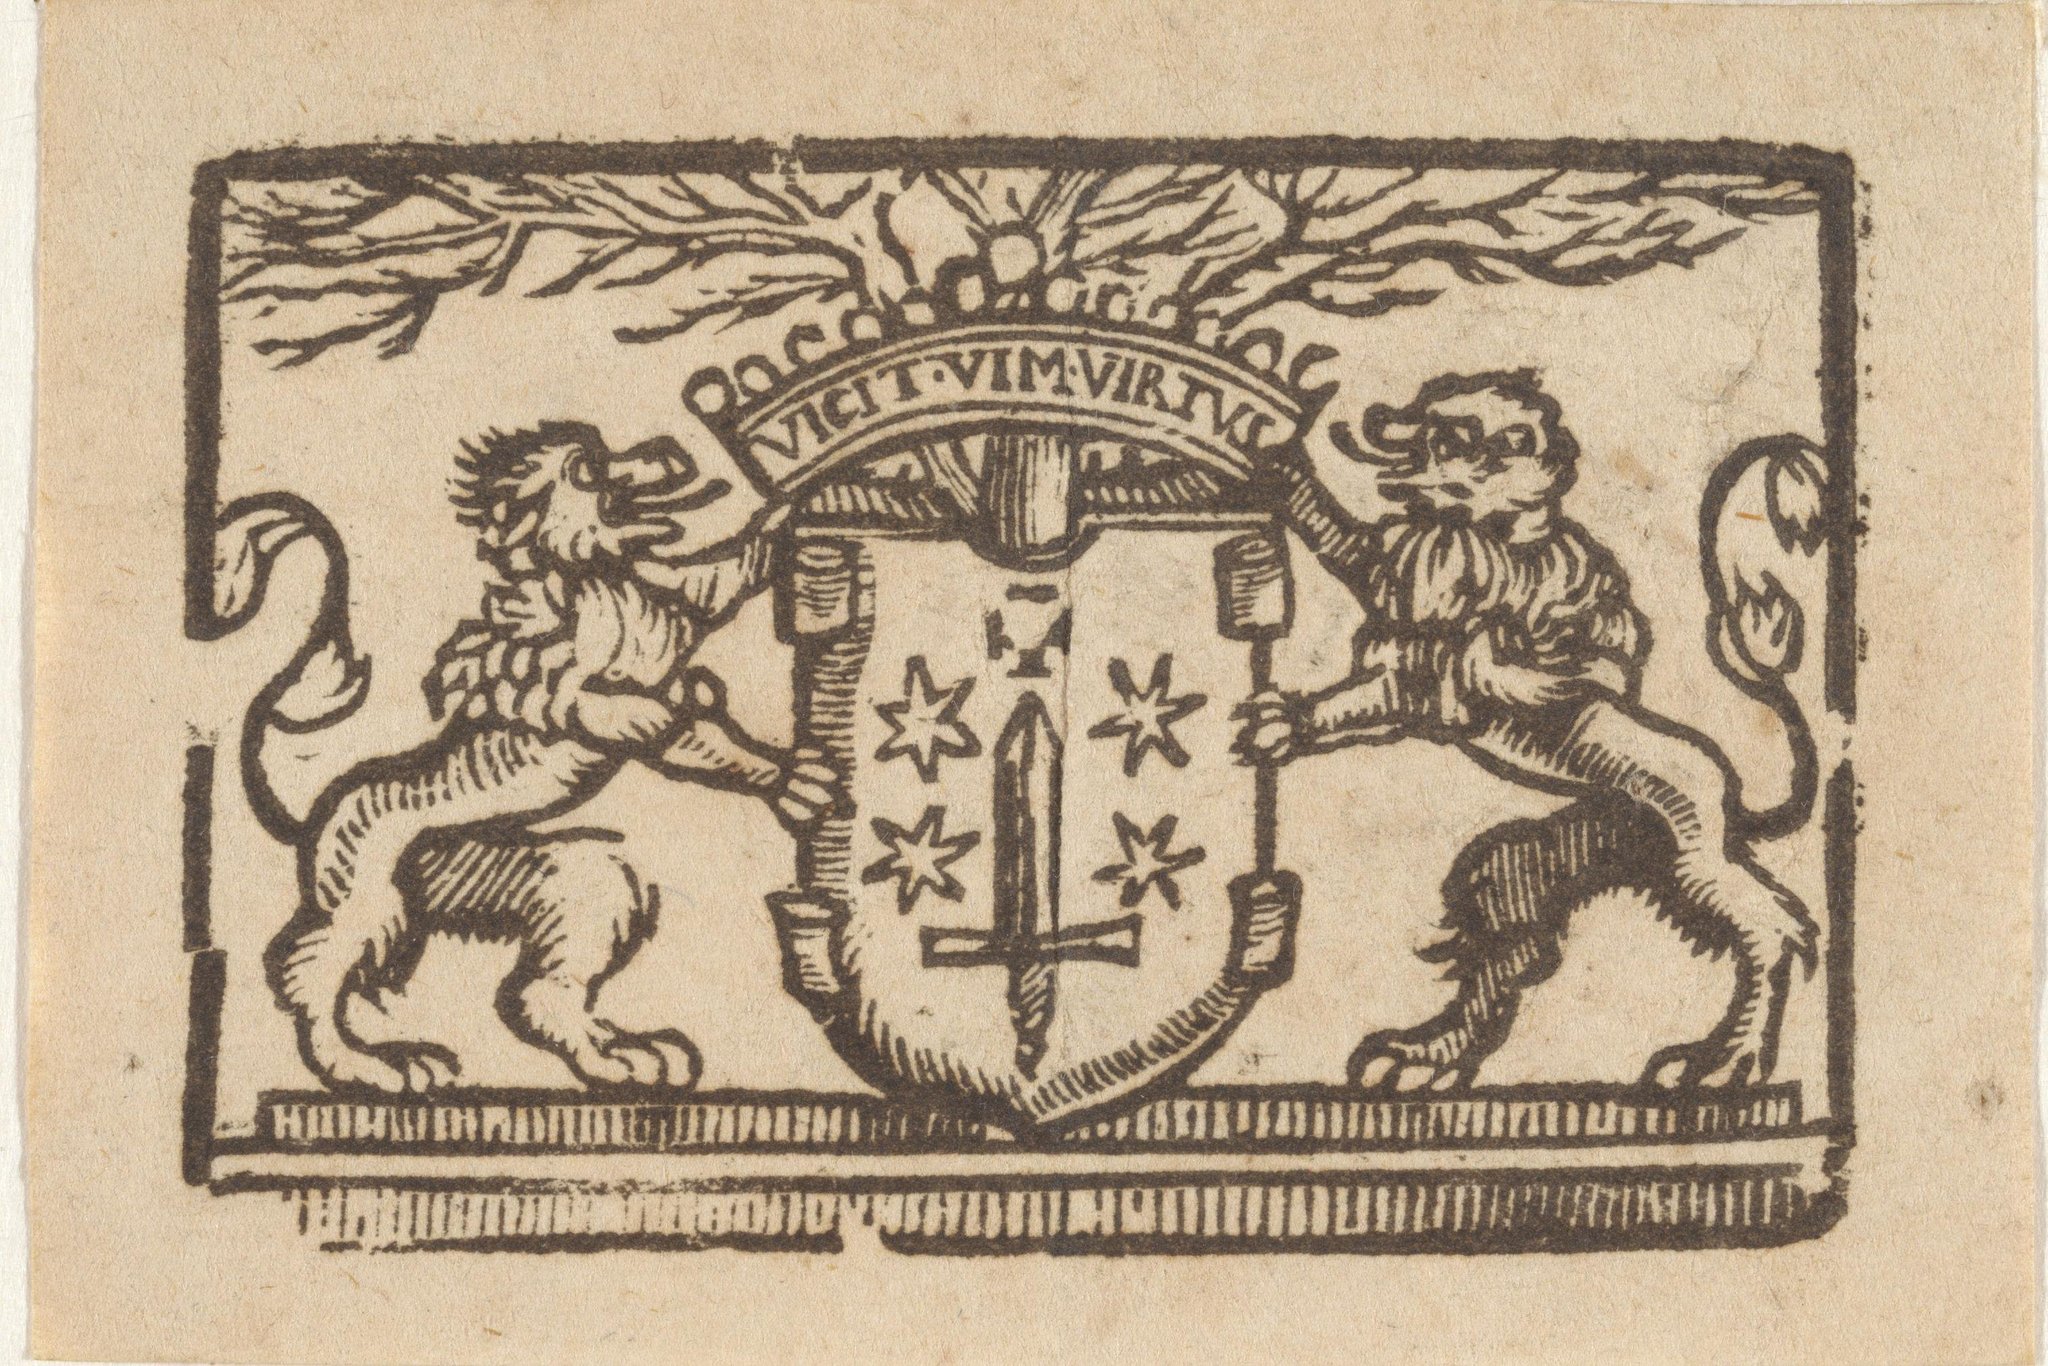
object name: print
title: Vignet met het wapen van de stad Haarlem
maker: Anonymous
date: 1600-1699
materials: paper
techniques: woodcut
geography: netherlands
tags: coat of arms (as symbol of the state, etc.) (+ city; municipal), vignette, haarlem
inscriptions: collector's mark: Lugt 240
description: Het wapen van de stad Haarlem met een boom, een kroon en twee leeuwen.